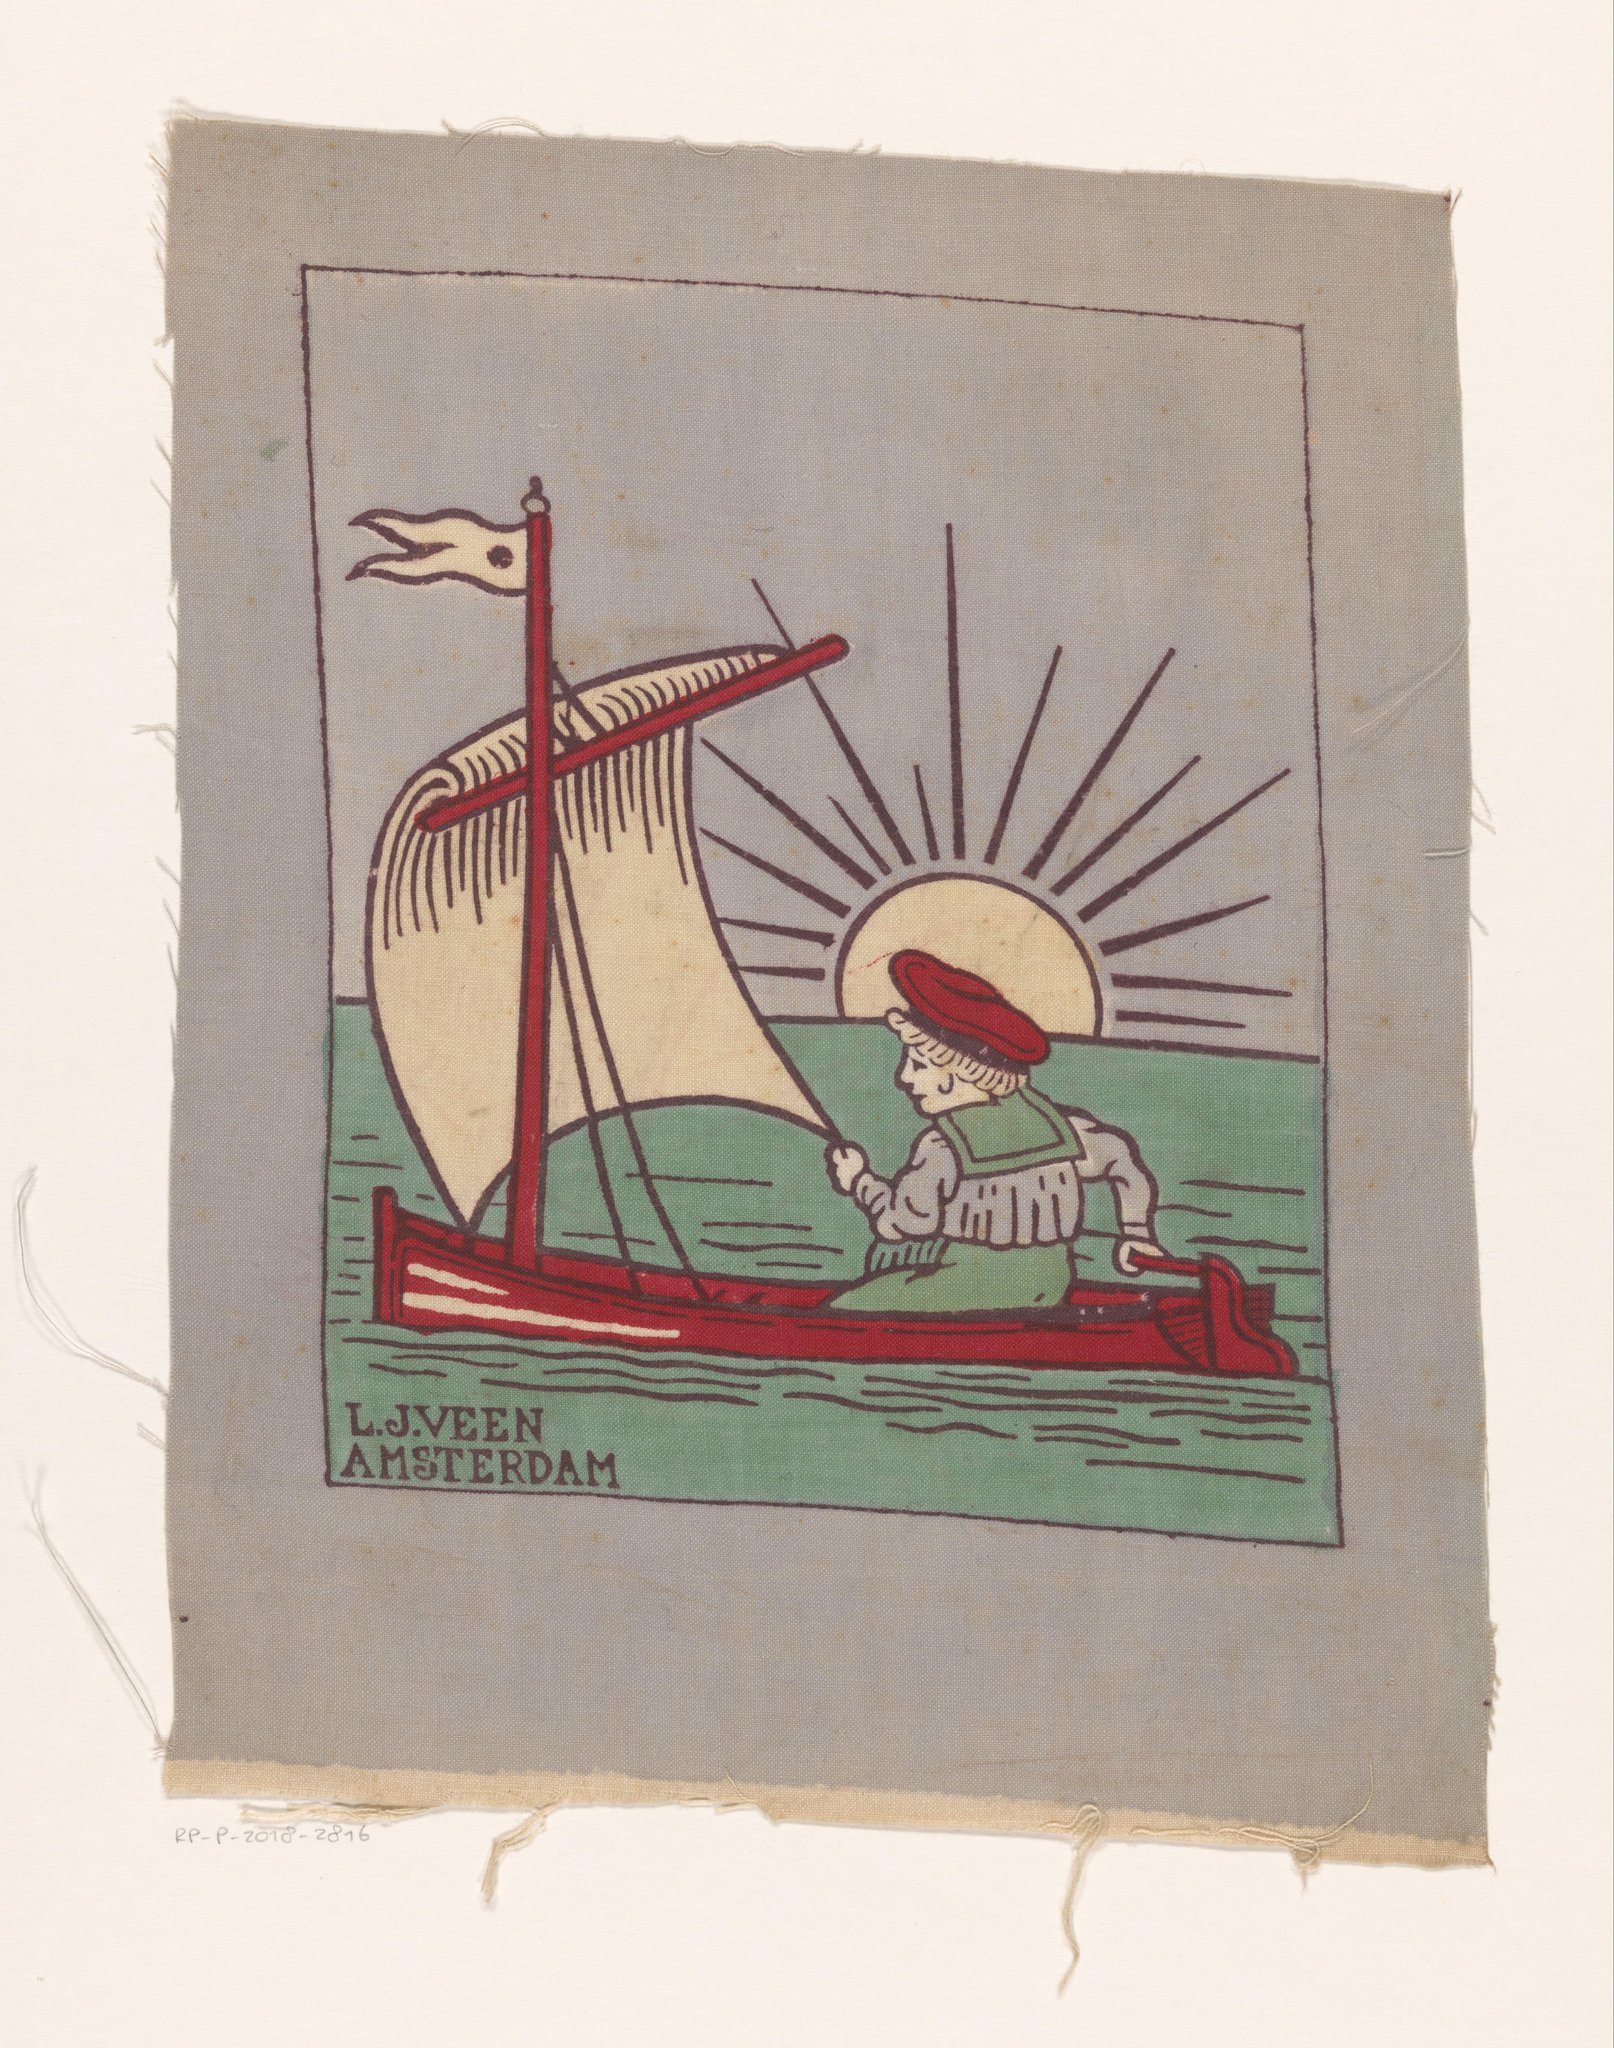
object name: study for binding design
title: Jongen in zeilboot bij opkomende zon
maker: Anonymous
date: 1890-1920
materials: ink, linen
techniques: printing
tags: sailing-ship, sailing-boat, boy (child between toddler and youth), sunrise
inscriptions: collector's mark: Lugt 2228